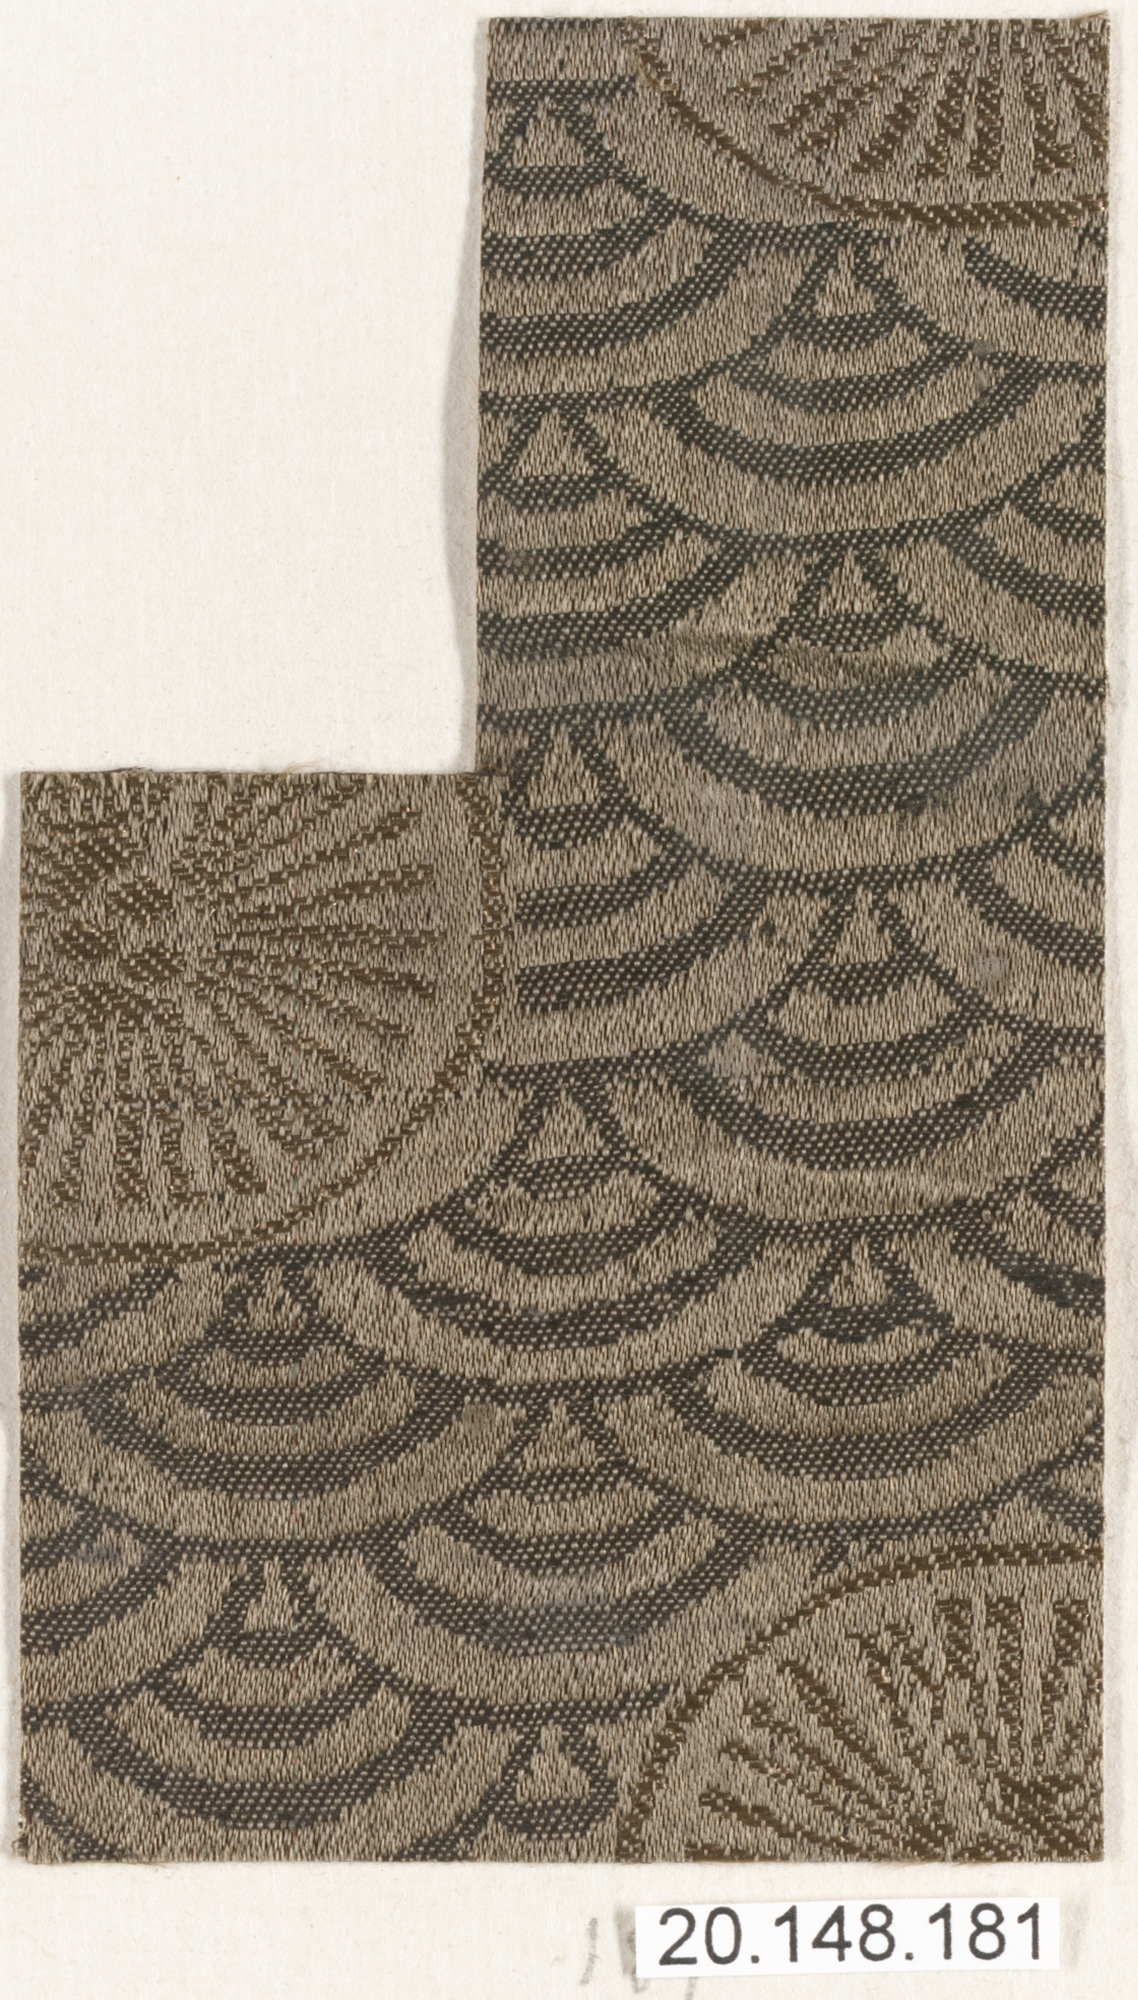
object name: piece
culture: japanese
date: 1701-1800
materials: silk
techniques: compound weave